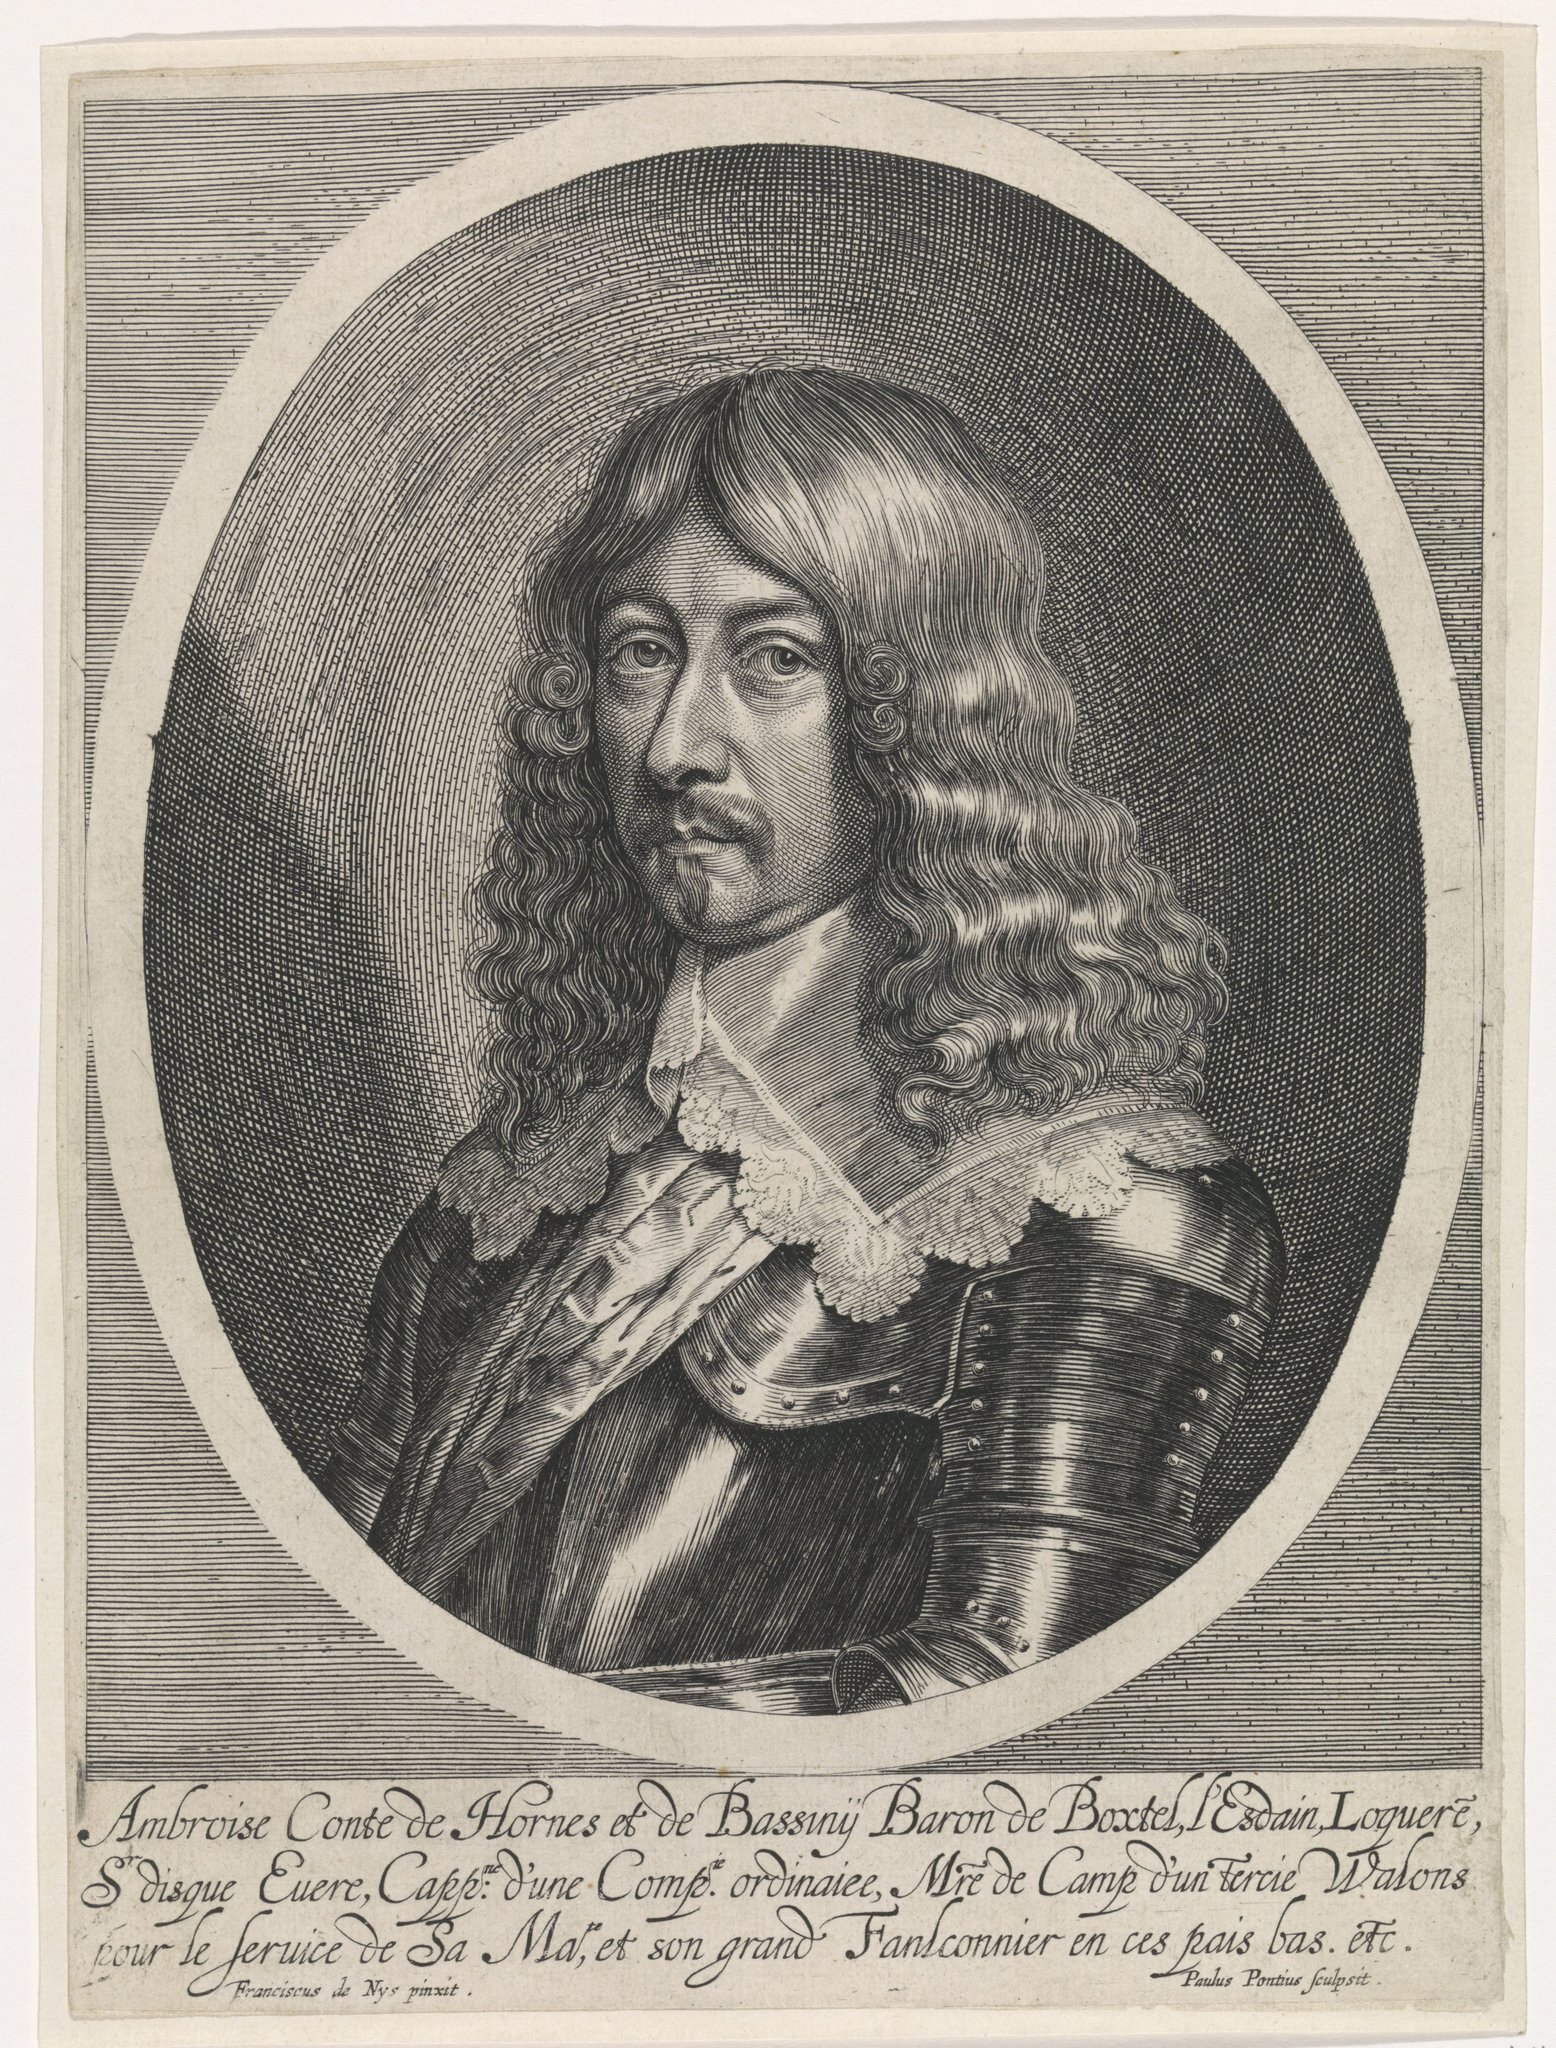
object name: print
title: Portret van Ambrosius, hertog van Hornes en Bassigny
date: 1616-1657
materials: paper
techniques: engraving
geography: antwerp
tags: armour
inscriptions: collector's mark: Lugt 2228